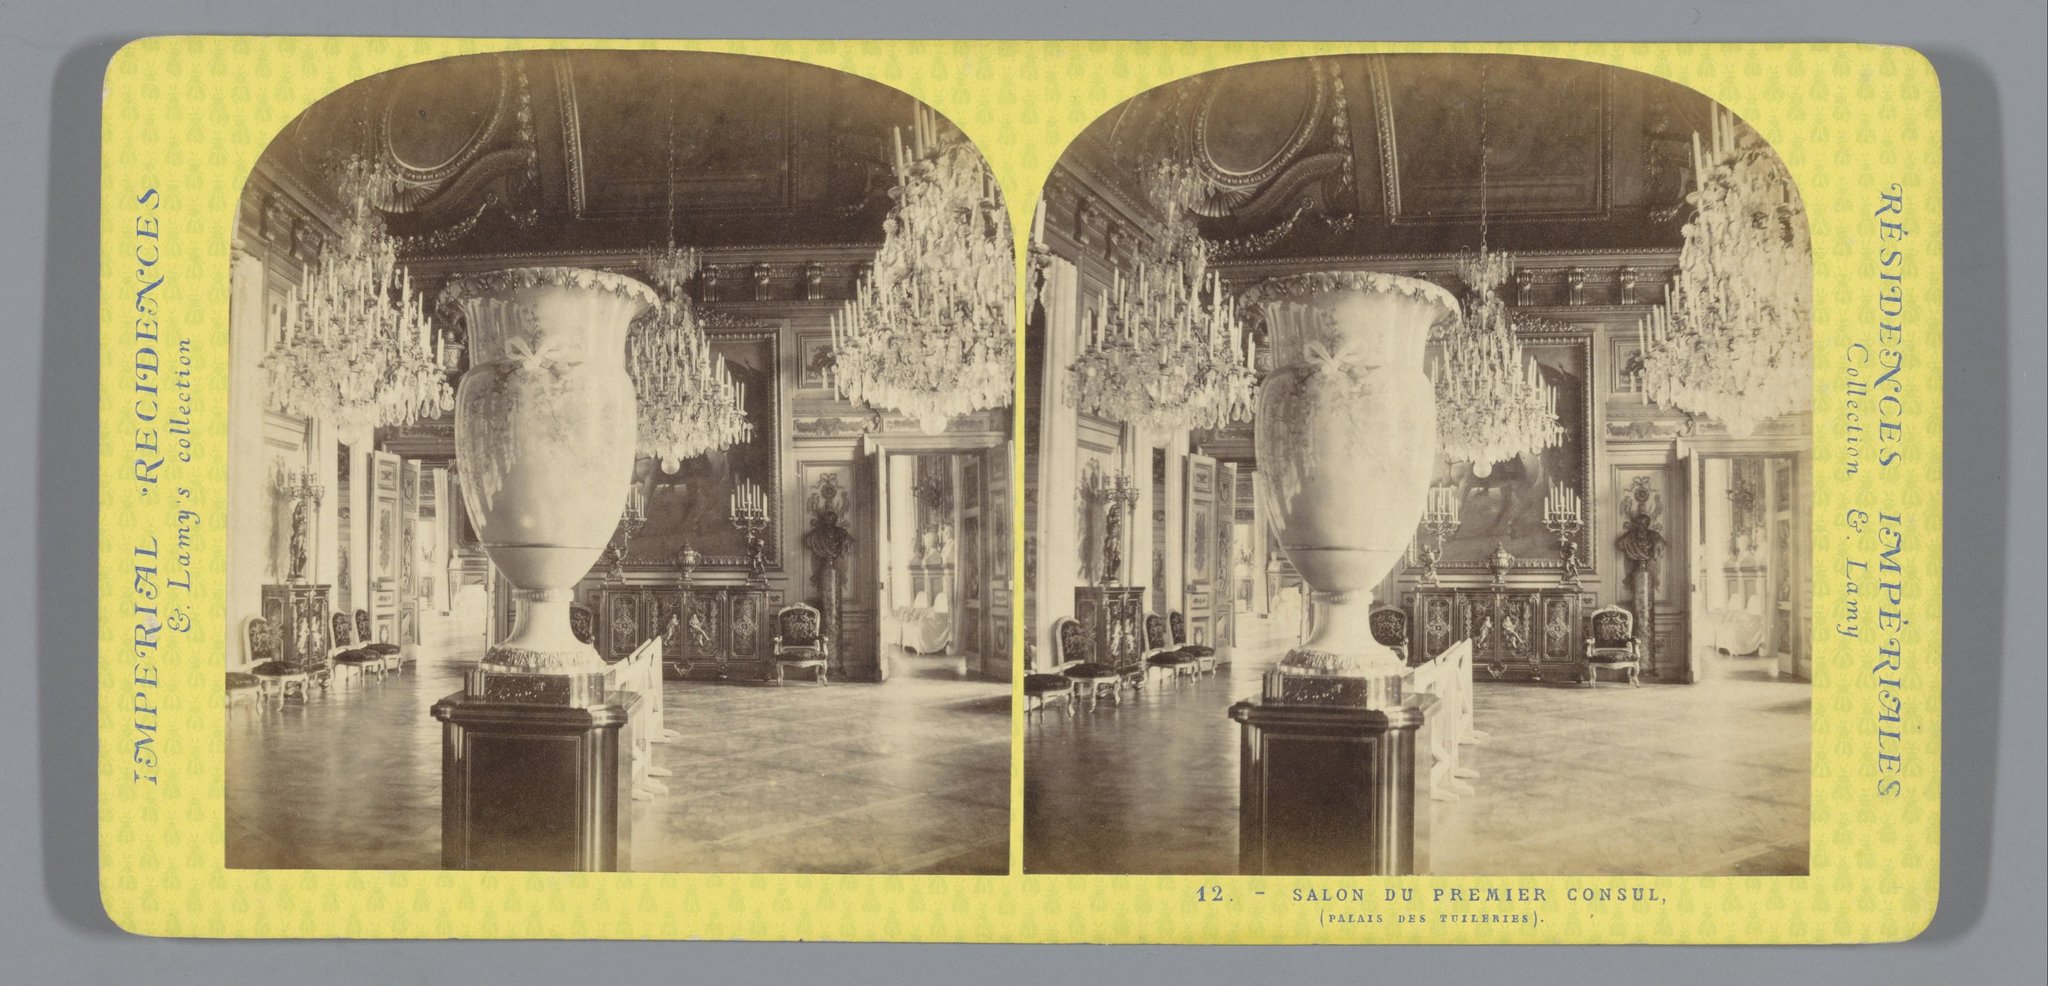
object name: stereograph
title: Imperial Residences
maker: ernest eléonor pierre lamy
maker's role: publisher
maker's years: 1828-1900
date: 1860-1871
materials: cardboard, photographic support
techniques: albumen print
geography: tuileries palace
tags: palace, interior ~ representation of a building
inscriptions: number: ‘12.’, inscription: ‘E. Lamy's collection’